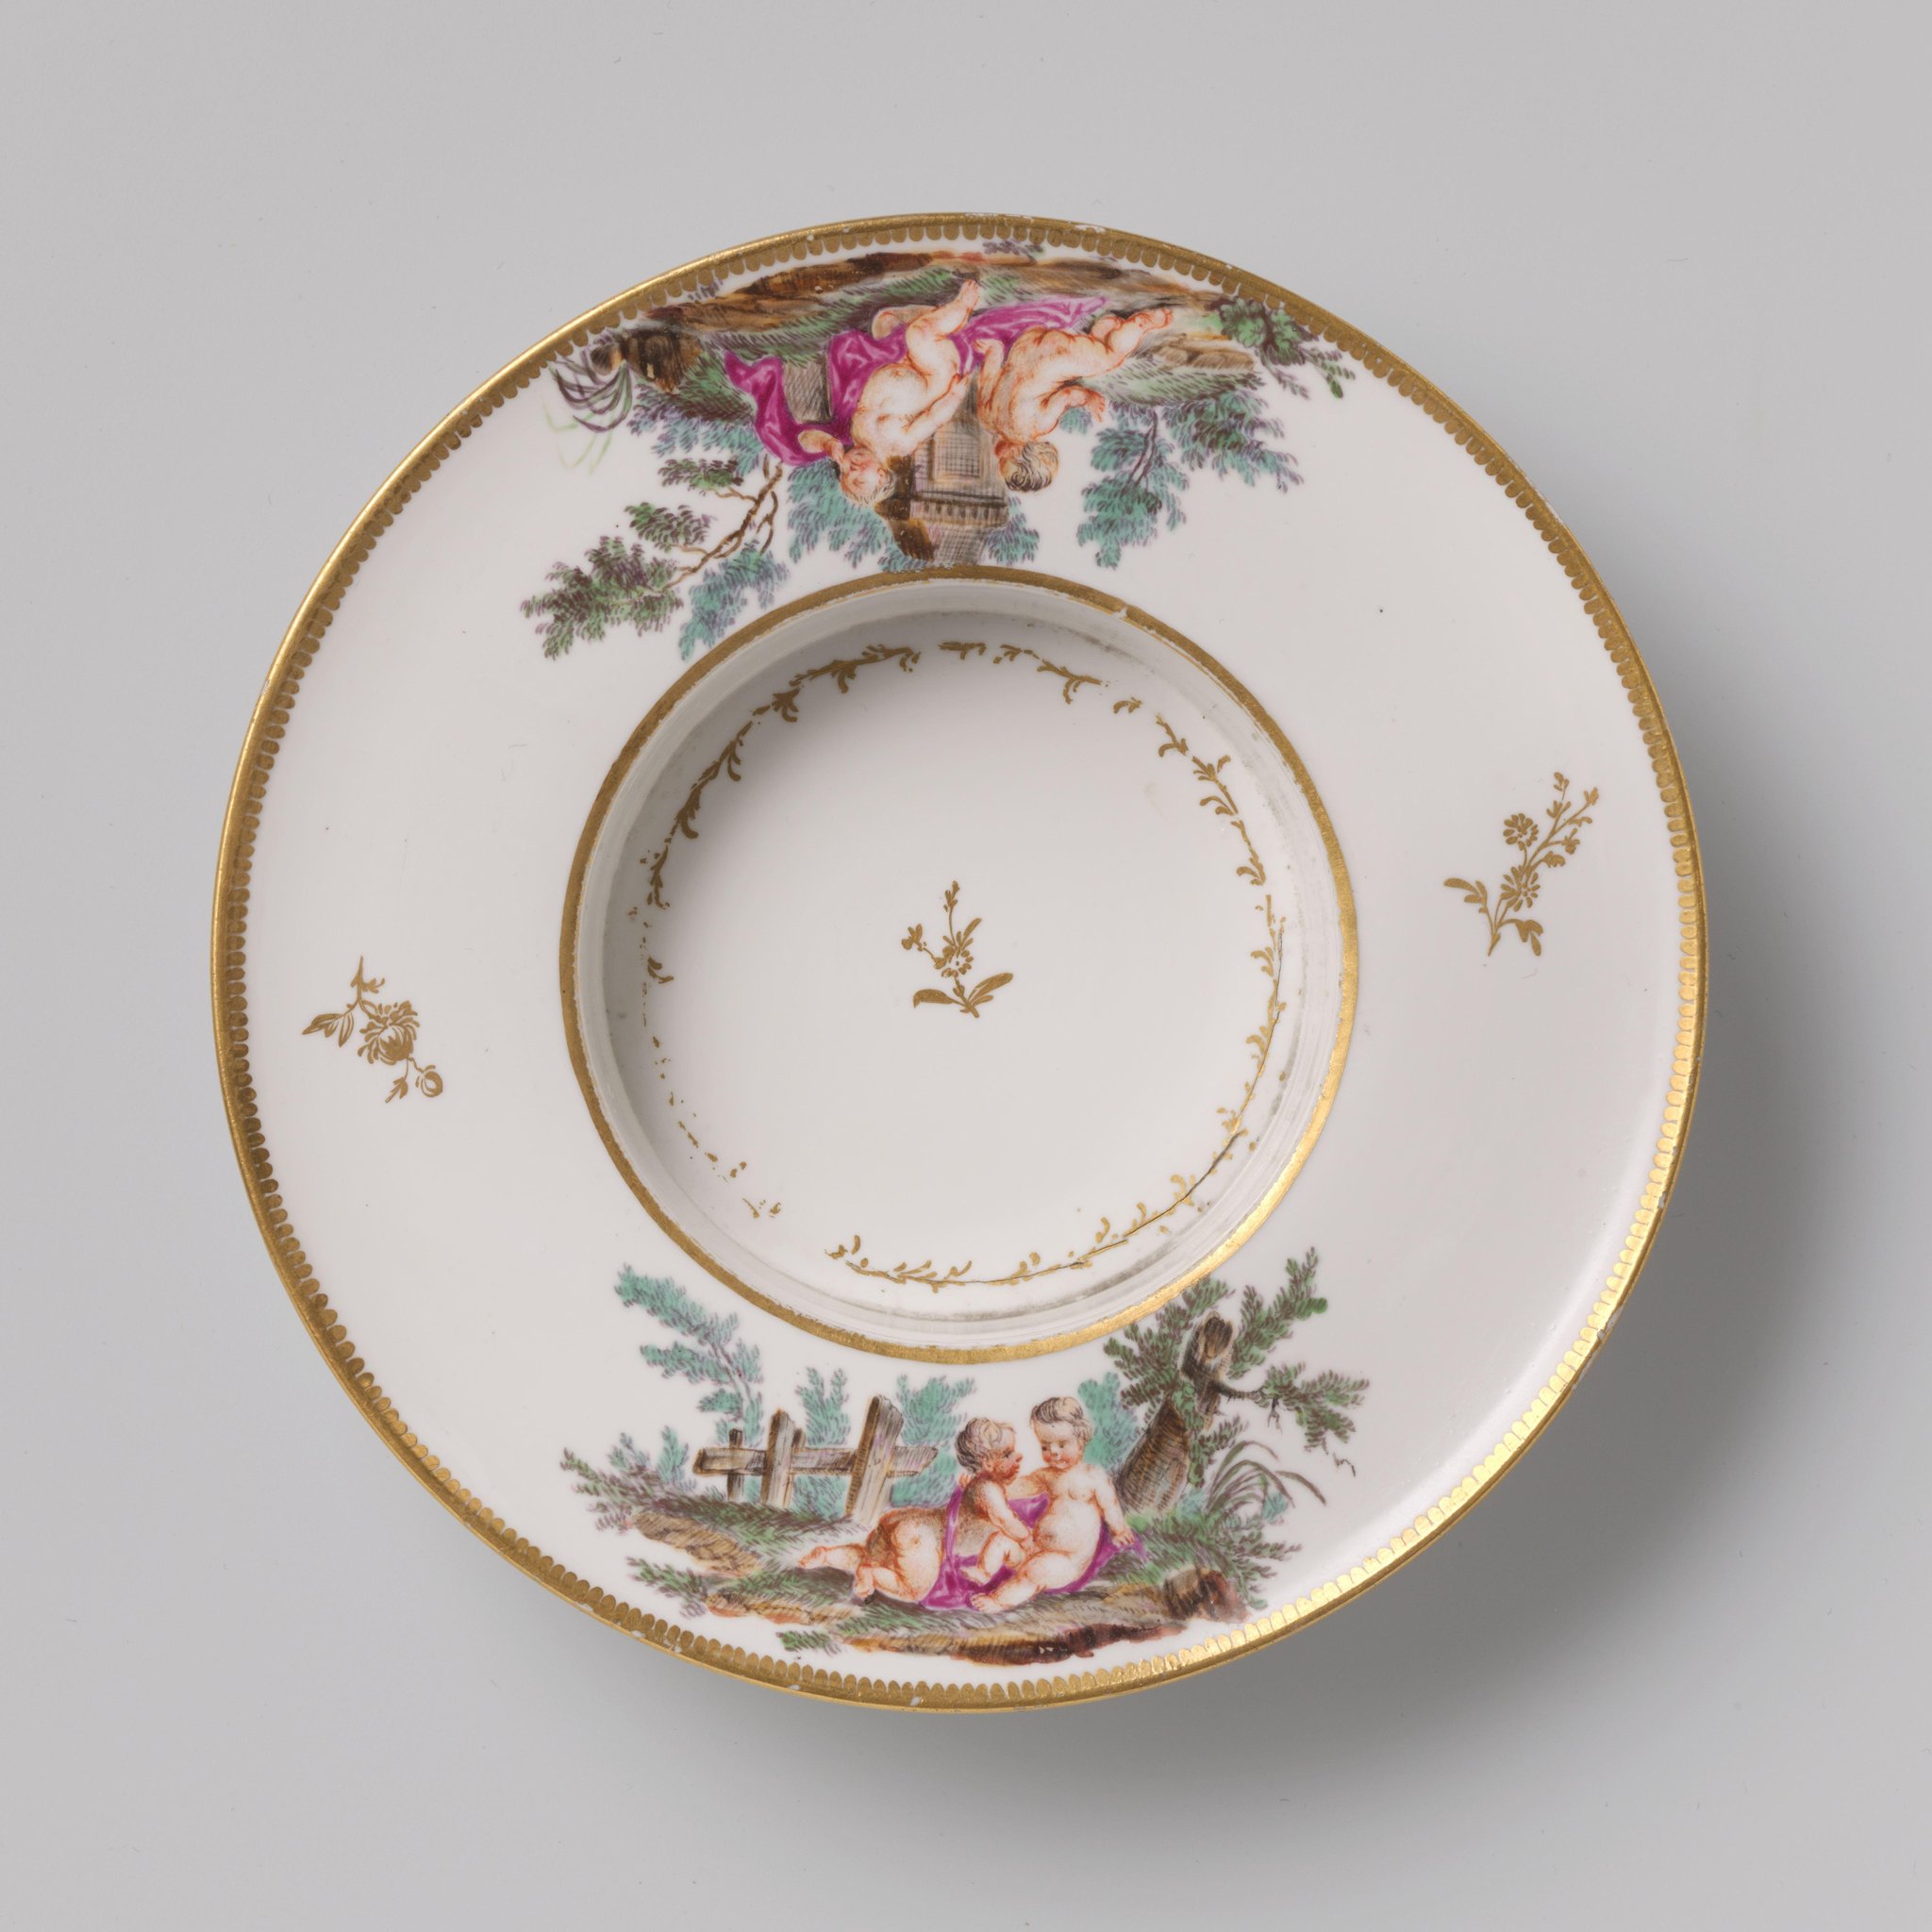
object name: trembleuse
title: Saucer with putti in a landscape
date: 1775-1785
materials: glaze, gold, paint, porcelain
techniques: firing, forming, gilding, vitrification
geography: höchst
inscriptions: mark: ‘wiel/ NI/ 9 / driehoek’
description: Schotel (trembleuse) van porselein met een diep centrum en platter rand, beschilderd op het glazuur in emailkleuren en goud. Op de rand tweemaal een landschap met twee putti, hiertussen gouden strooibloemen. Het plat met een bloemtak en een bladrank. Band met gouden bollen op de rand. Gemerkt op de onderzijde met het wiel, NI, 9 en een diehoek.